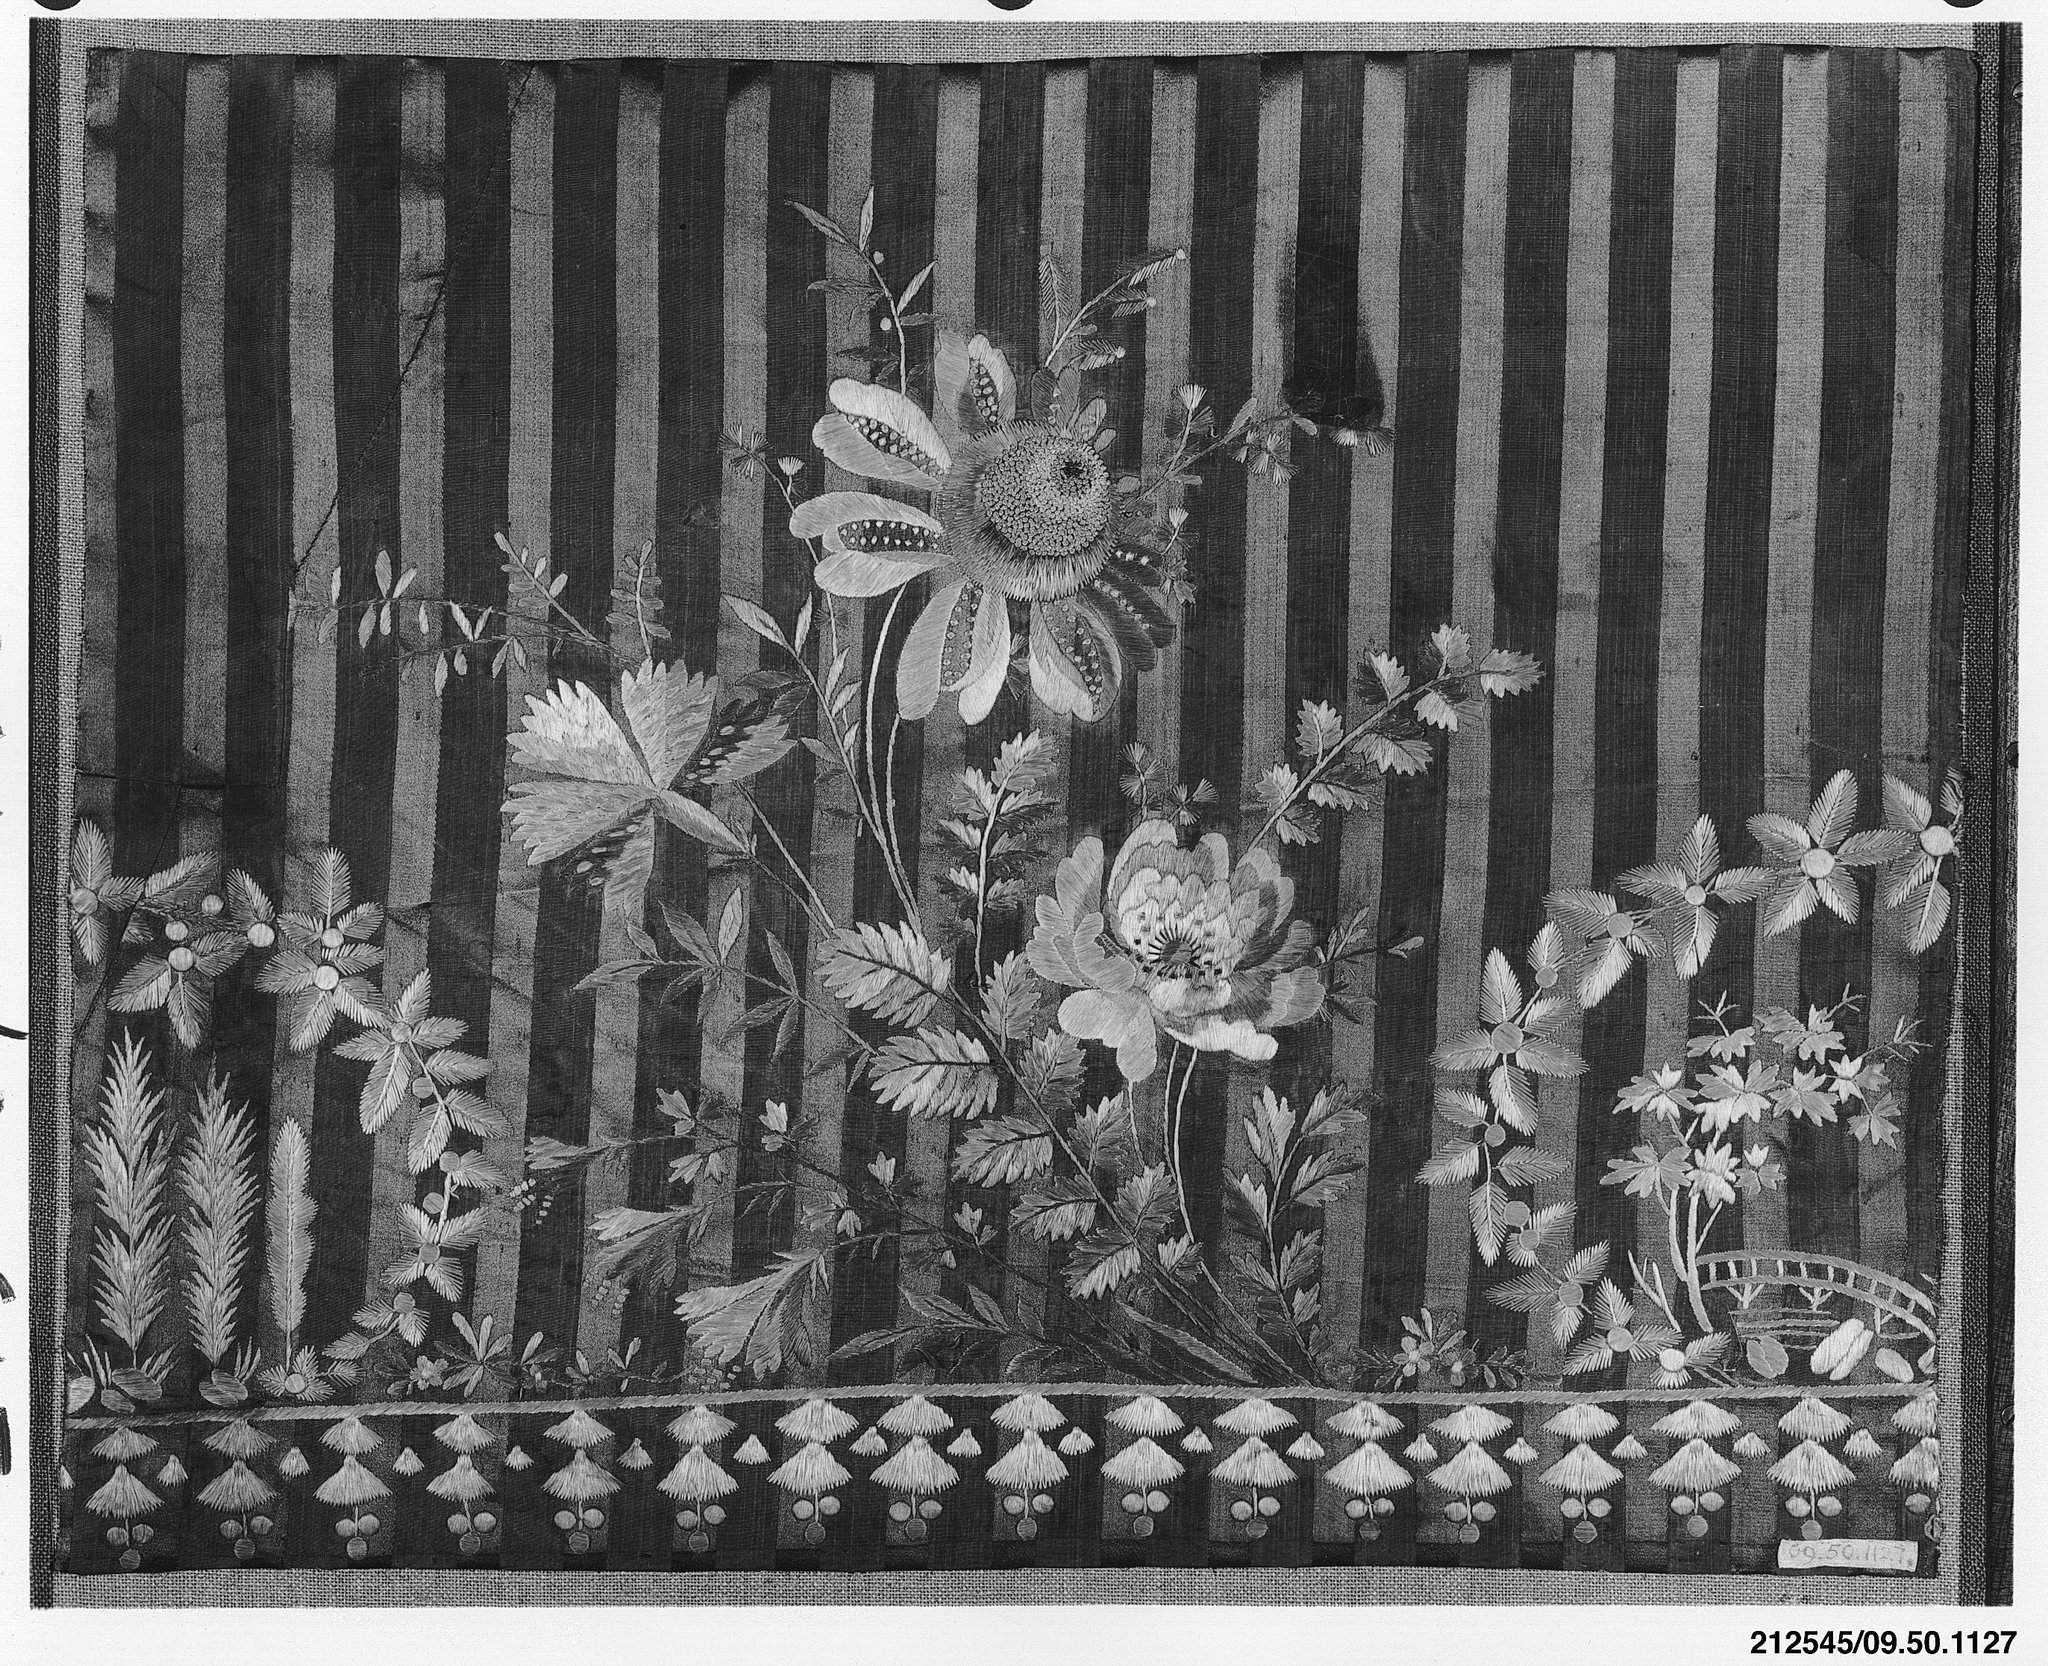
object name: border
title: Dress border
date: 1801-1833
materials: silk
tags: flowers,leaves